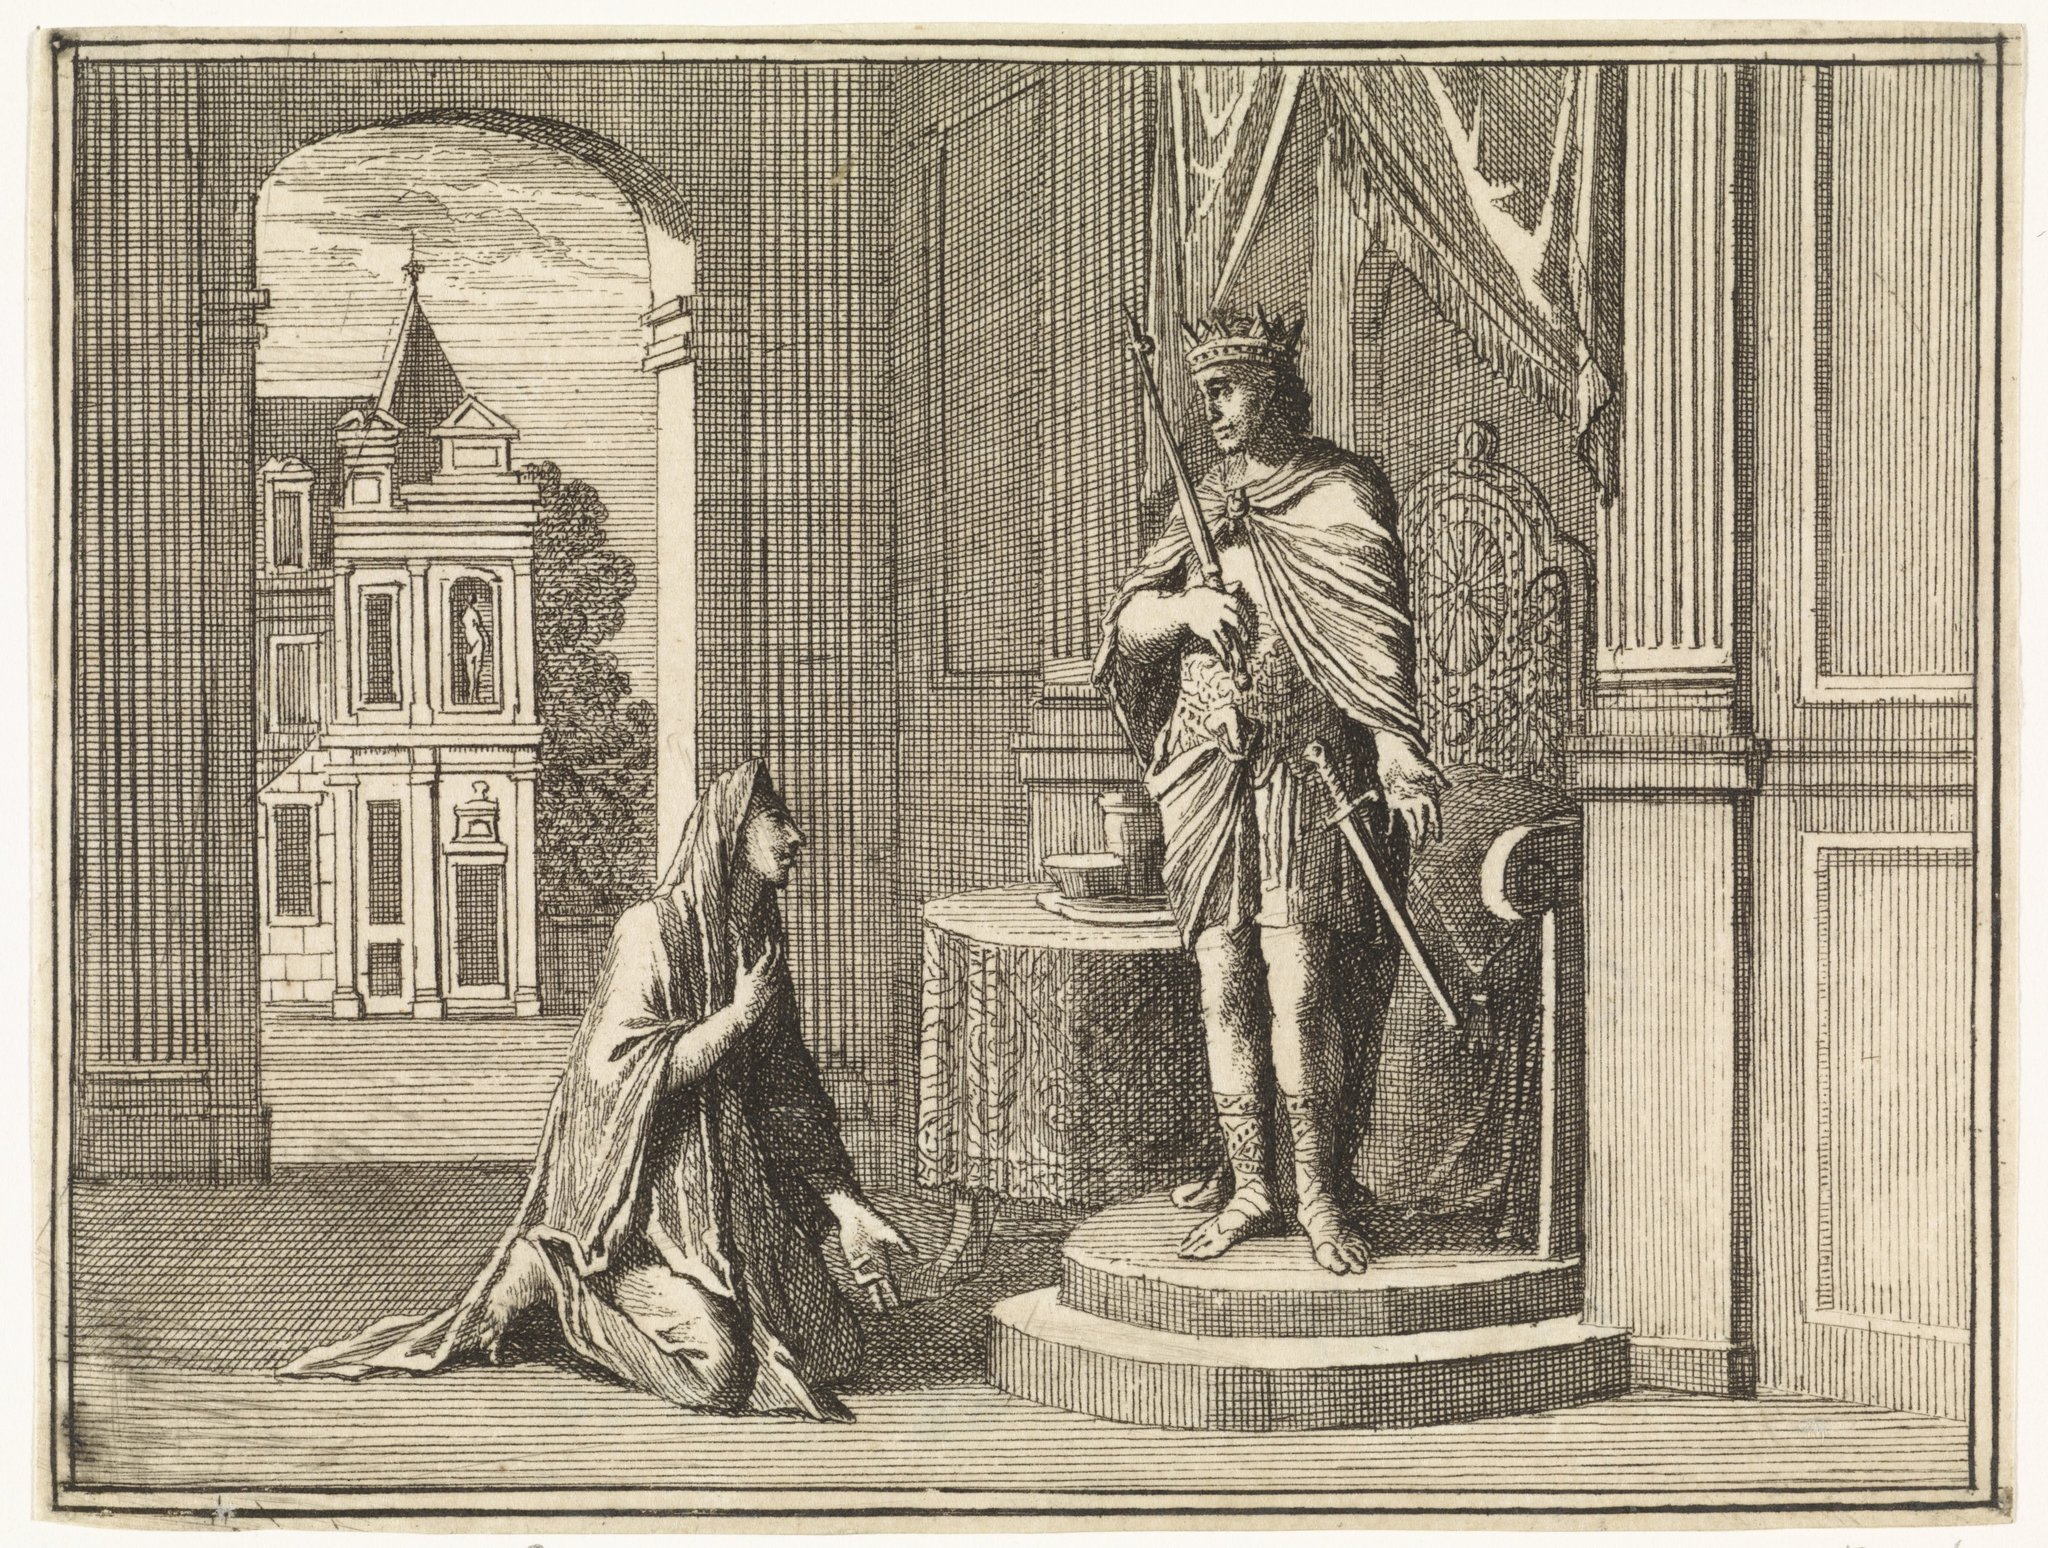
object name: print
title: Wijze vrouw uit Tekoa in gesprek met David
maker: caspar luyken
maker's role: draughtsman, print maker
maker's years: 1672-1708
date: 1712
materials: paper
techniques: etching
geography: amsterdam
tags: david and the woman of tekoah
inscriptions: number: ‘114’, collector's mark: Lugt 2228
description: Illustratie uit: Luyken, Jan. De schriftuurlyke geschiedenissen en gelykenissen van het Oude en Nieuwe Verbond, 2 delen. Amsterdam: Wed. Pieter Arentsz II en Cornelis van der Sys, 1712, dl. I.